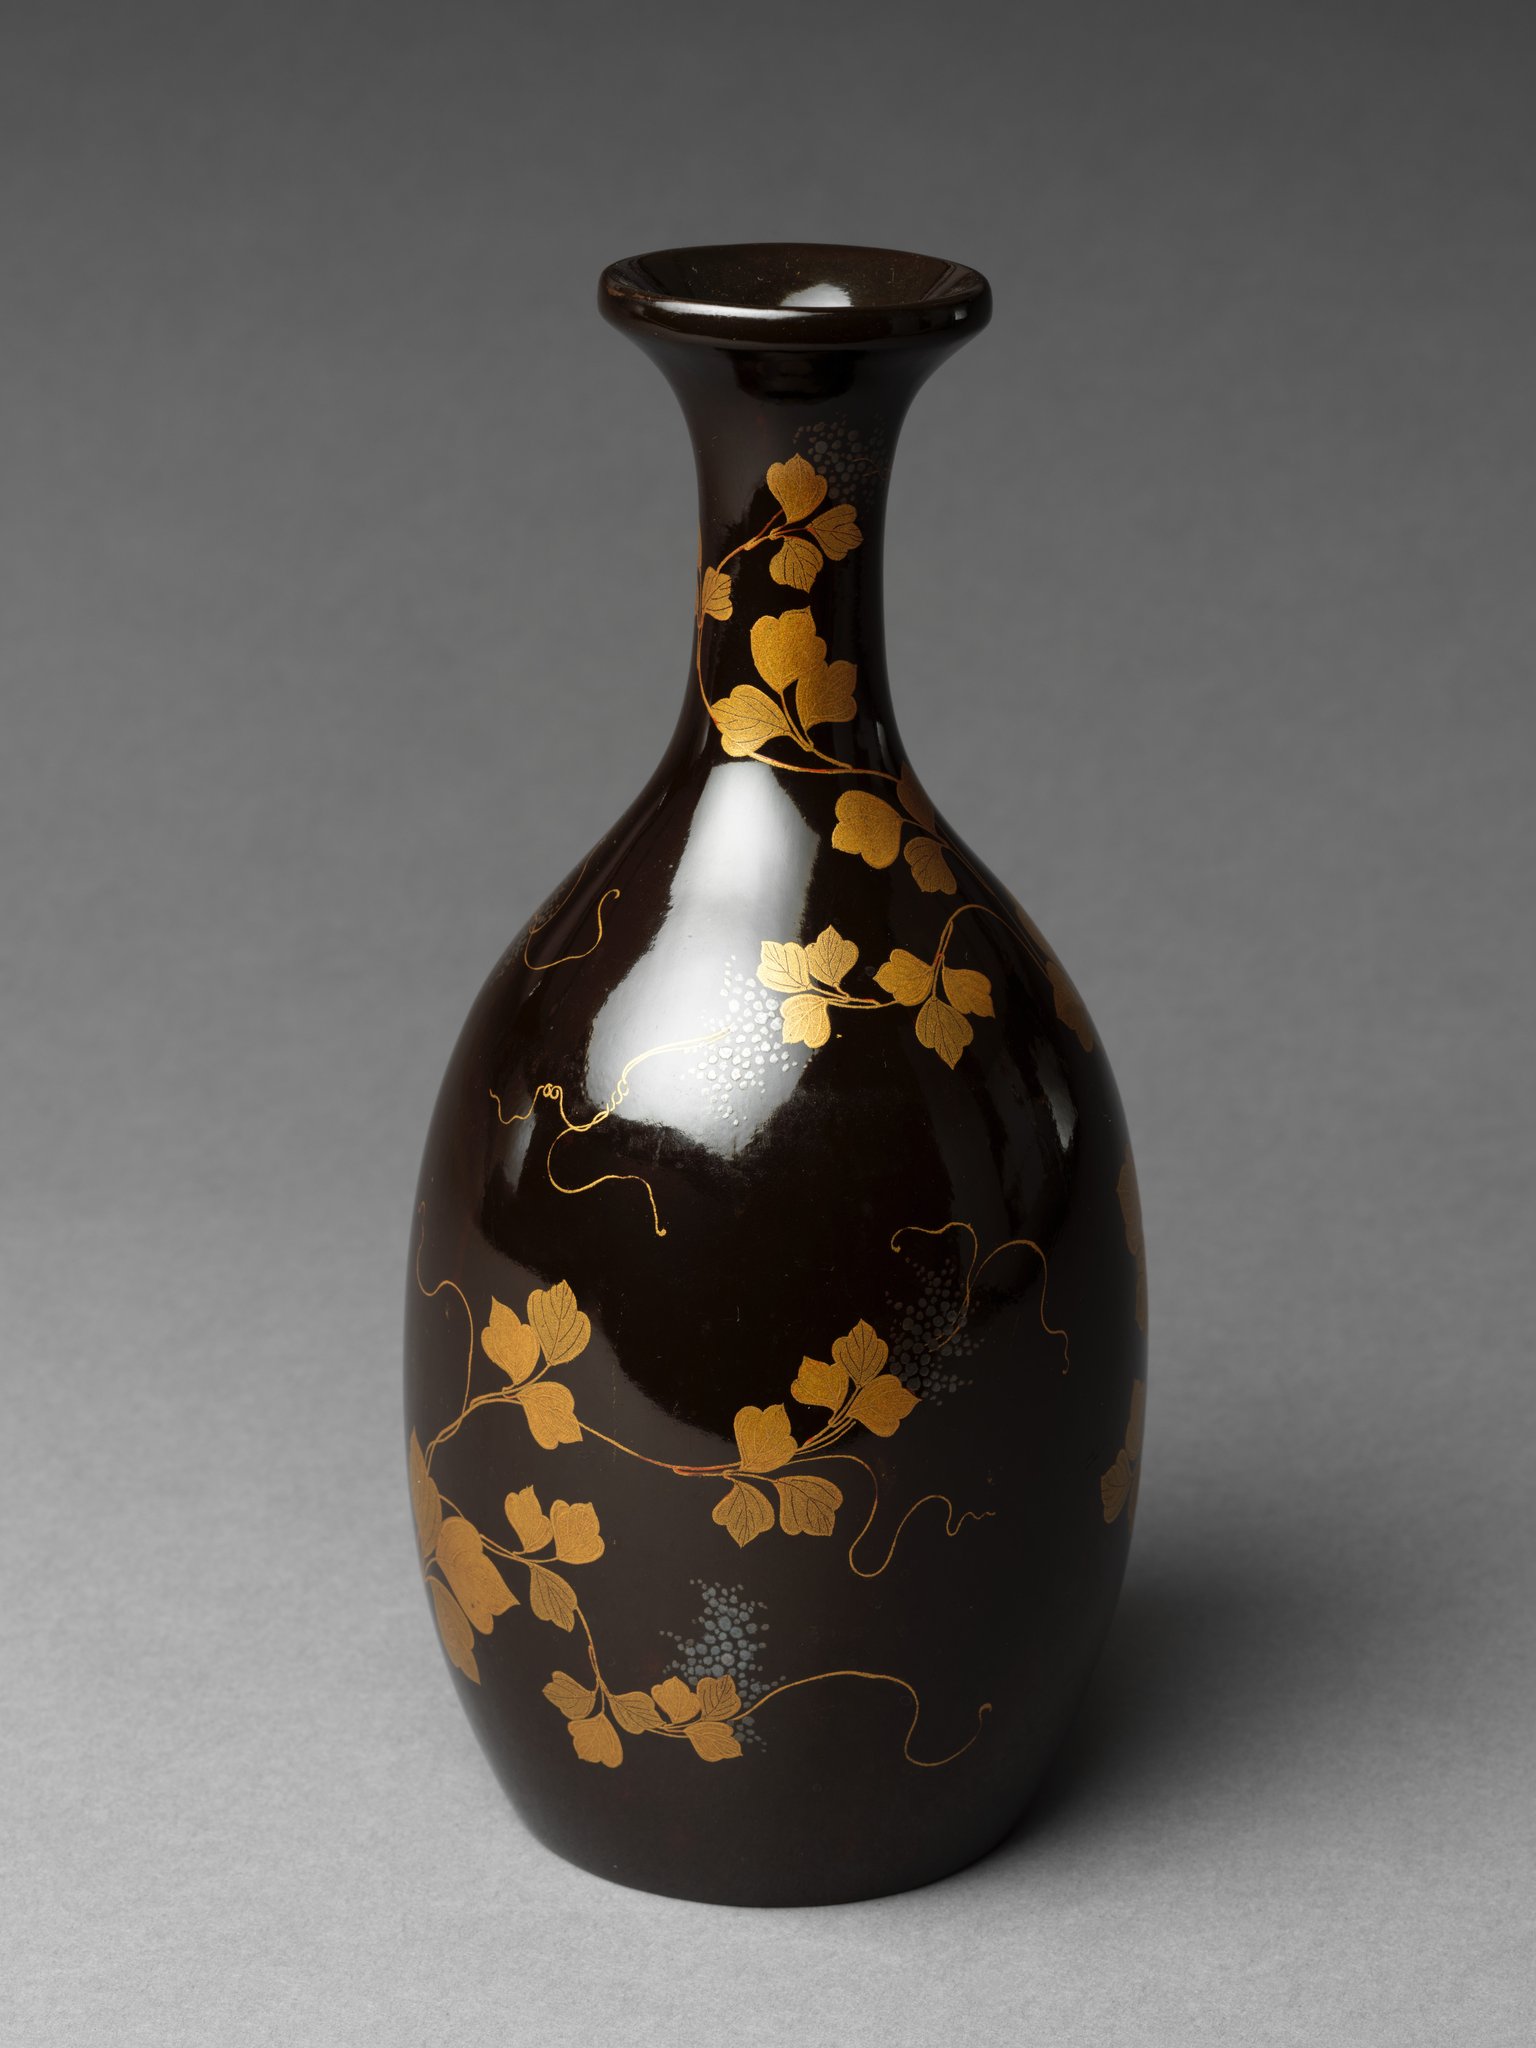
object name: sake bottle one of a pair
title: Sake bottle with grapevine decoration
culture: japanese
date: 1651-1700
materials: gold, lacquer, silver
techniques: maki